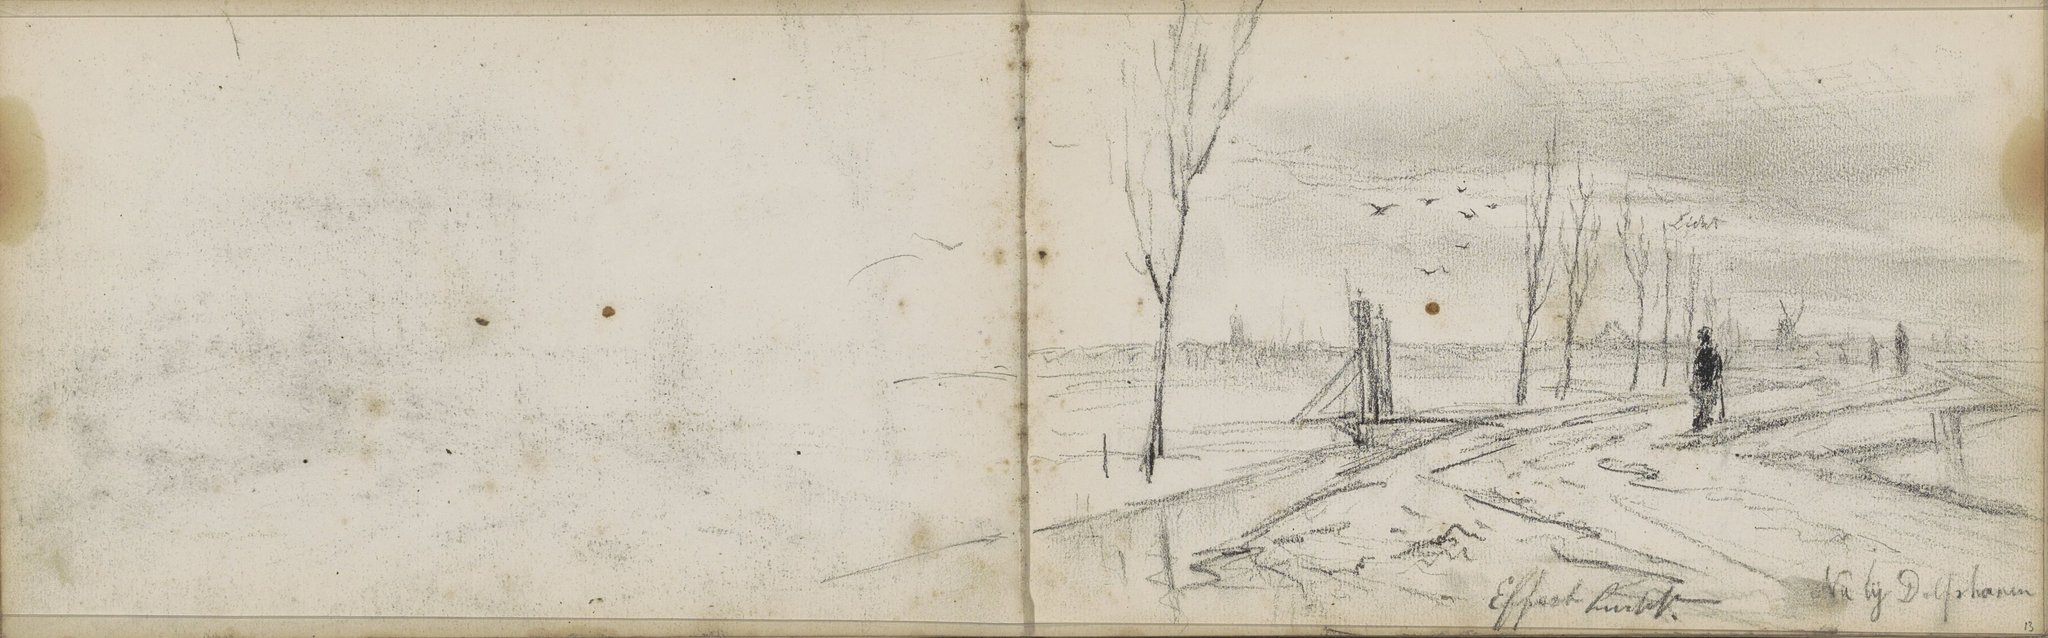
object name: sketchbook leaf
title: Polderlandschap met figuren op een pad bij Delfshaven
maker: willem cornelis rip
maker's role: draughtsman, painter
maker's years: 1856-1922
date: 1876-1877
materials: paper, pencil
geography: delfshaven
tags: road, path, landscapes (+ landscape with figures, staffage), delfshaven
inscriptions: annotation: ‘Nu bij Delfshaven’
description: Blad 12 verso en 13 recto uit een schetsboek met 41 bladen.